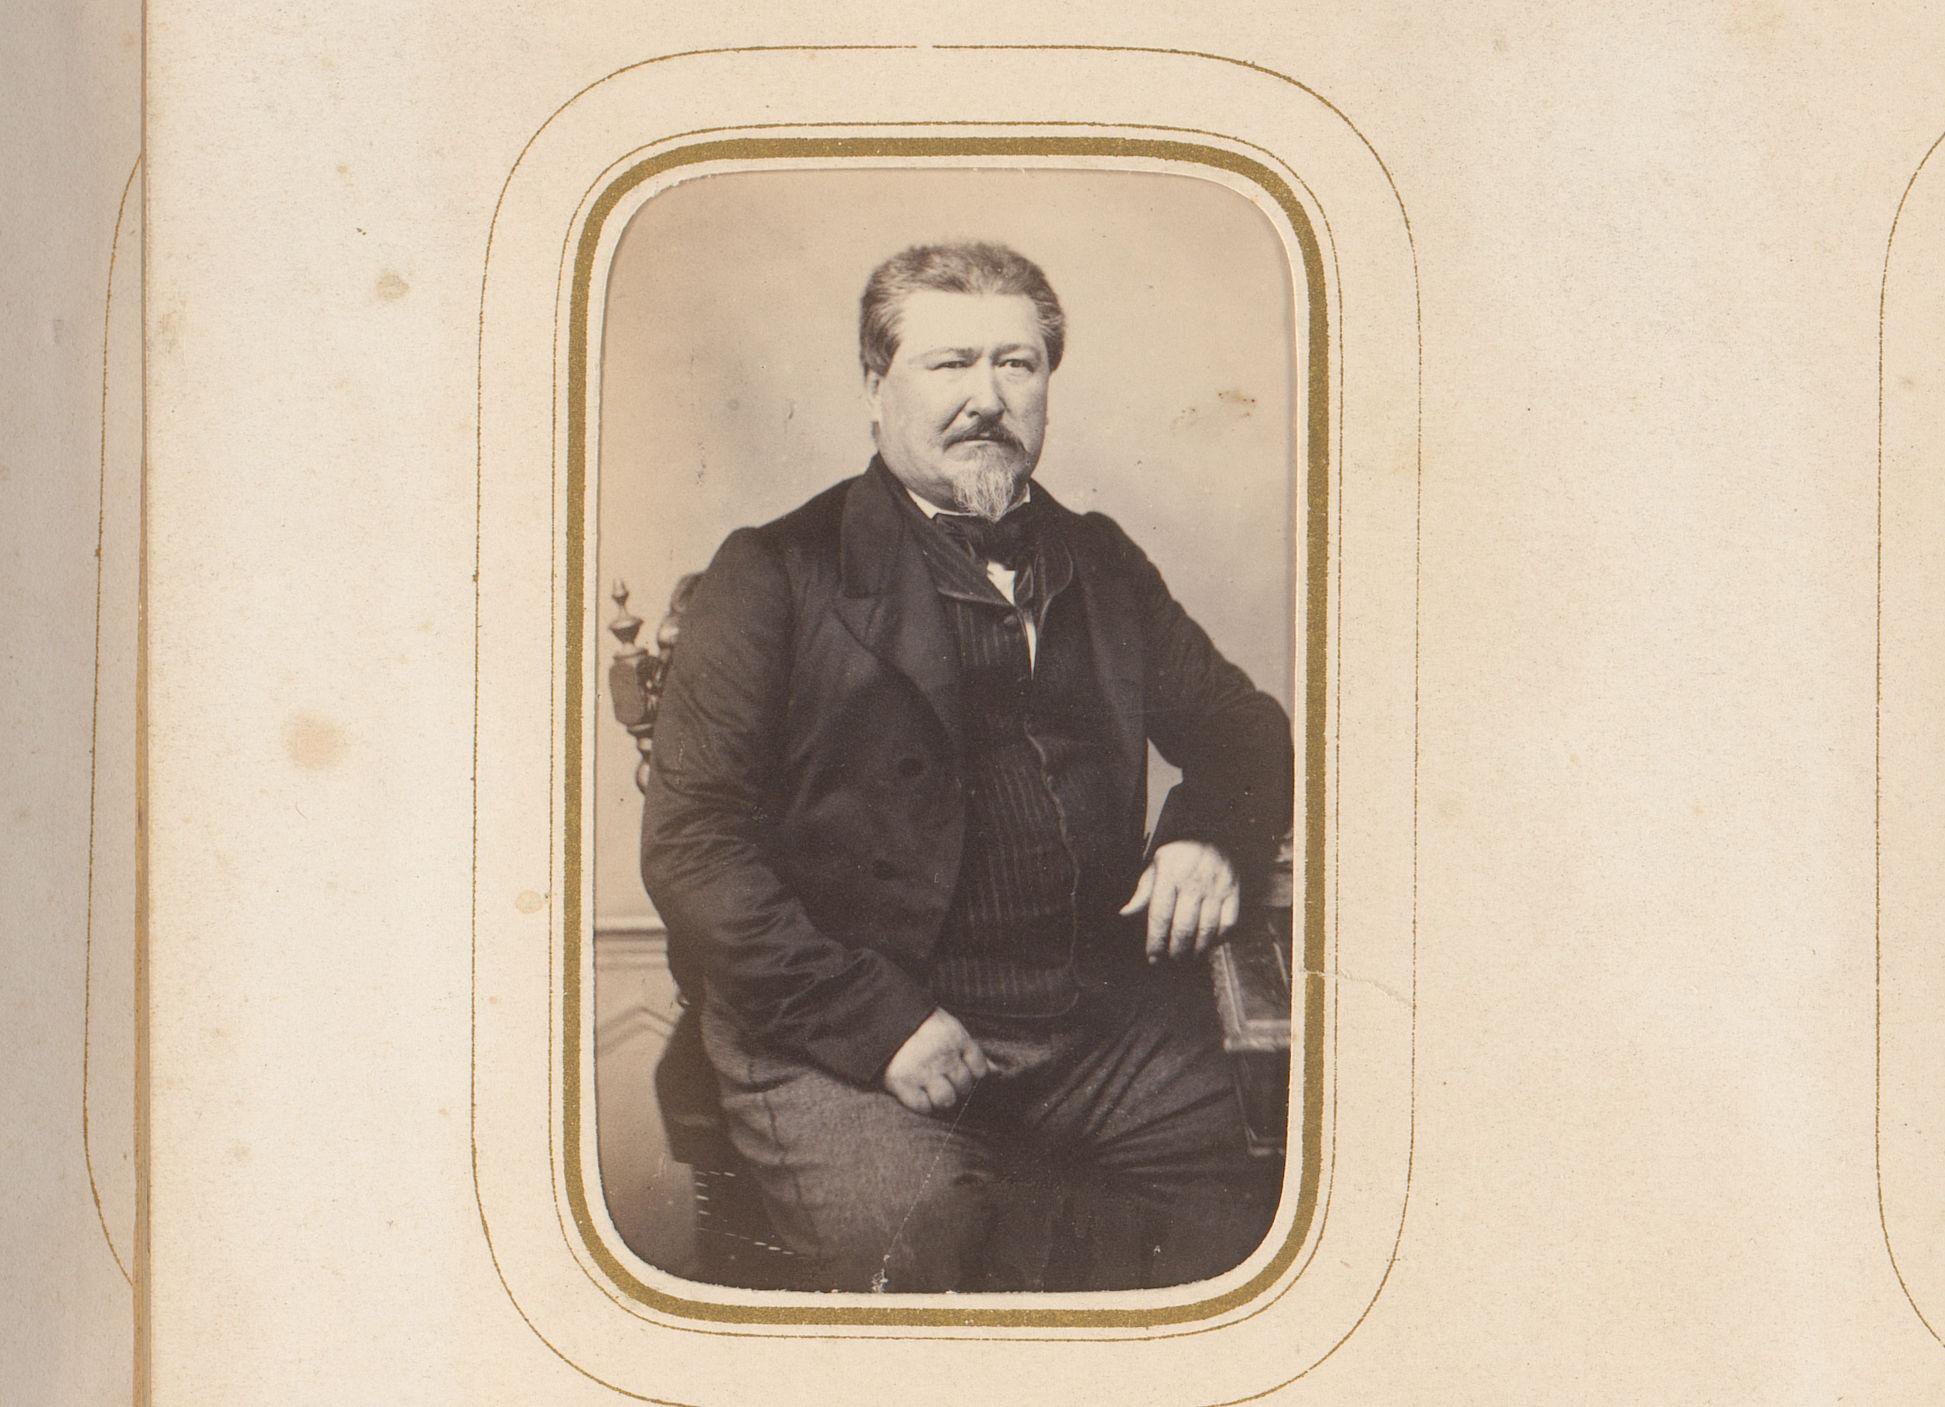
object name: photograph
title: Portret van een zittende man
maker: a. dupuy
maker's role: fotograaf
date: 1860-1900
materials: cardboard, photographic support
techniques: albumen print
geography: paris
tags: moustache, historical persons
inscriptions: inscription: ‘Photographie/ A. Dupuy/ 150, Rue de Rivoli/ Paris’, inscription: ‘A. Dupuy phot.’